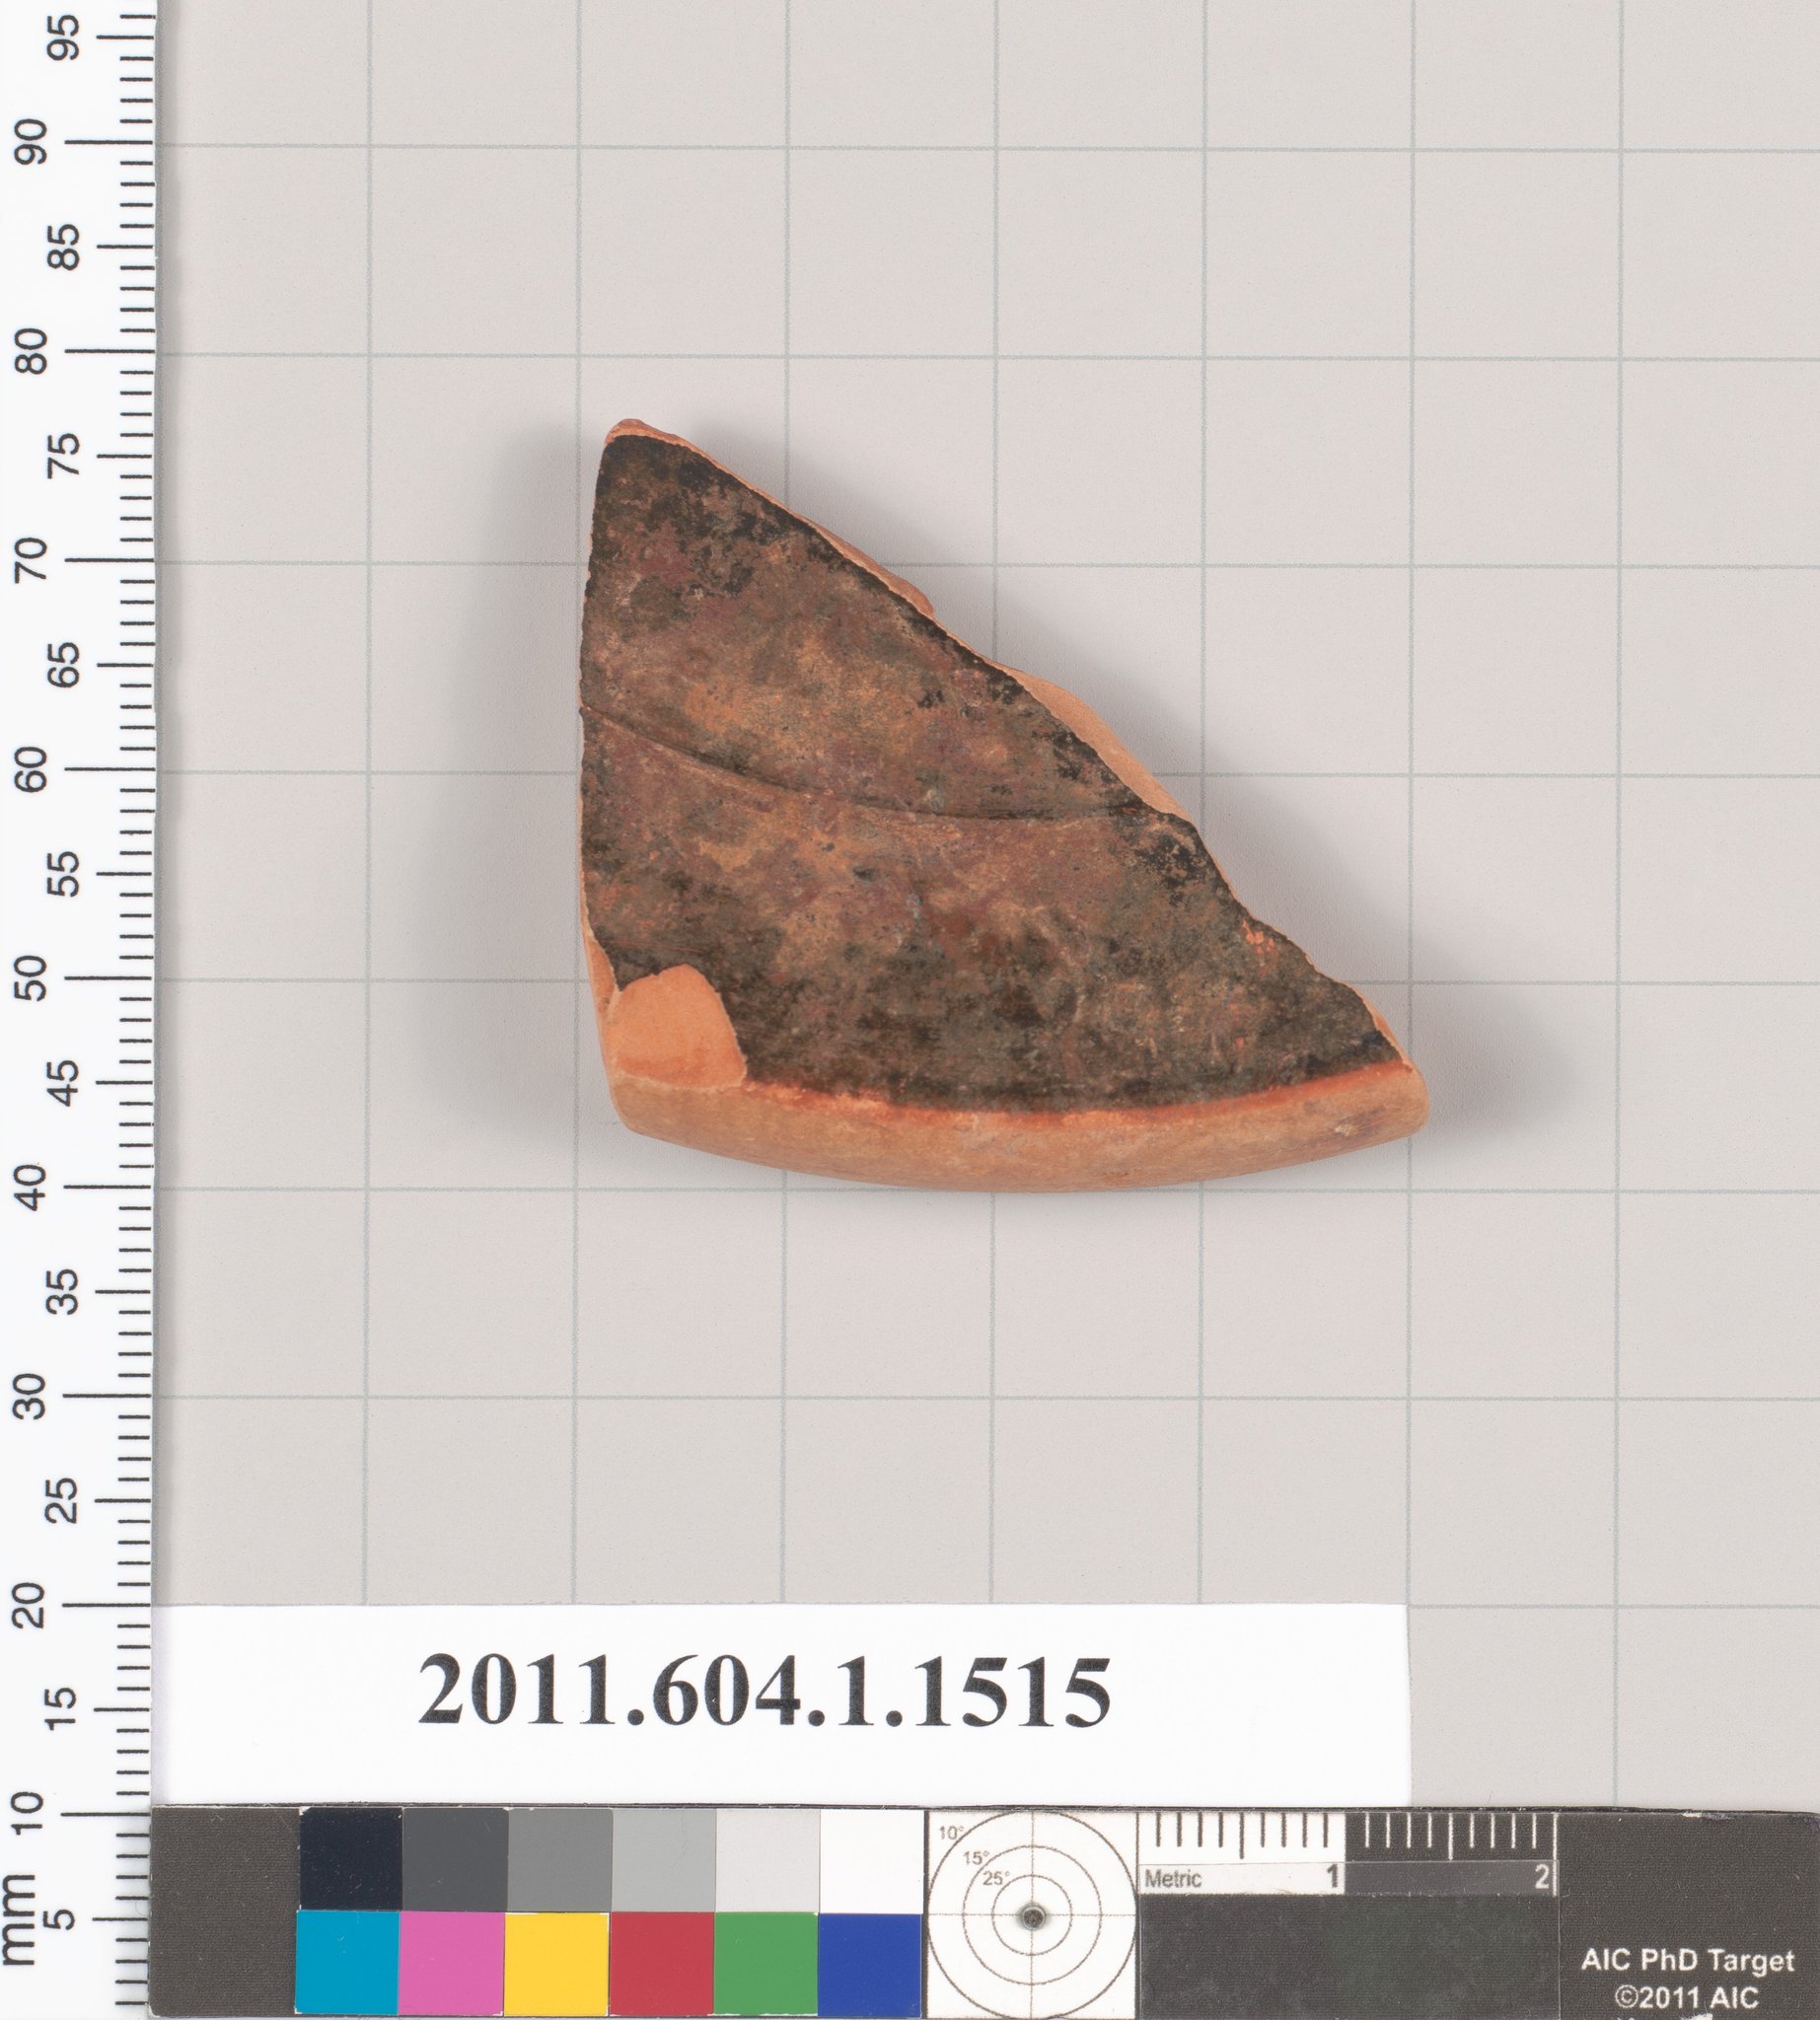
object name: kylix fragment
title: Terracotta fragment of a kylix (drinking cup)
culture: greek, attic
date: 500-401 BCE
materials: terracotta